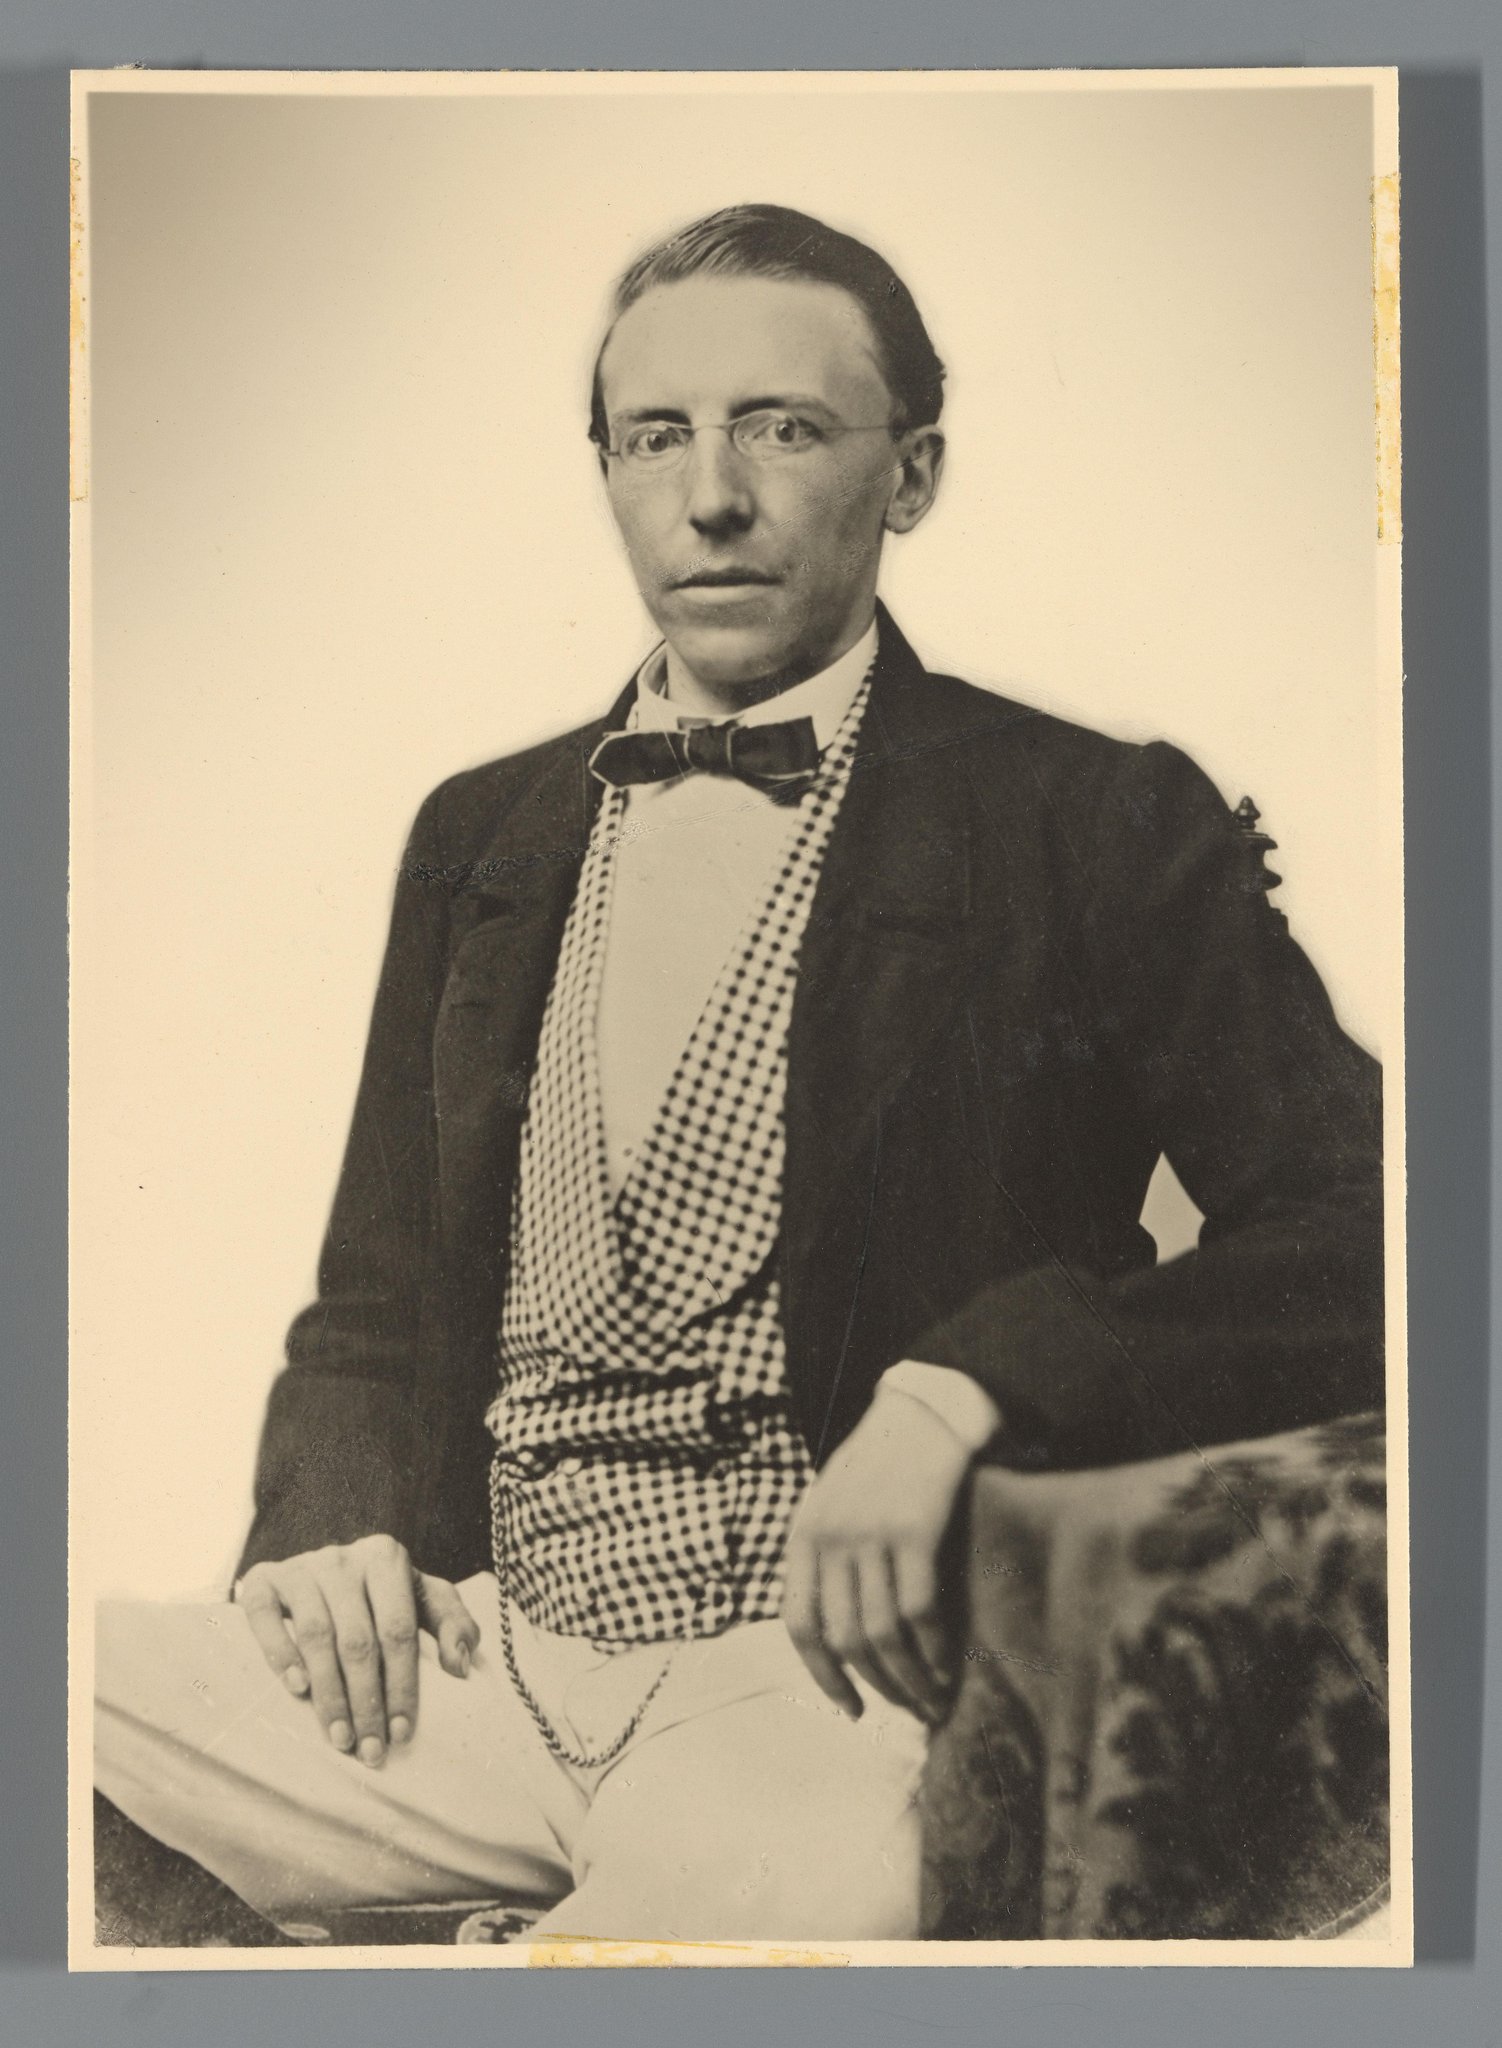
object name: photograph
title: Norbert Petrus van den Berg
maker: Anonymous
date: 1863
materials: photographic support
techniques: albumen print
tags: rotterdam, amsterdam, norbertus petrus van den berg (1831-1917)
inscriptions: inscription: ‘R2422 / 3 uur / mr N.P. van den Berg / 1831 - 1917 / ± 1863’